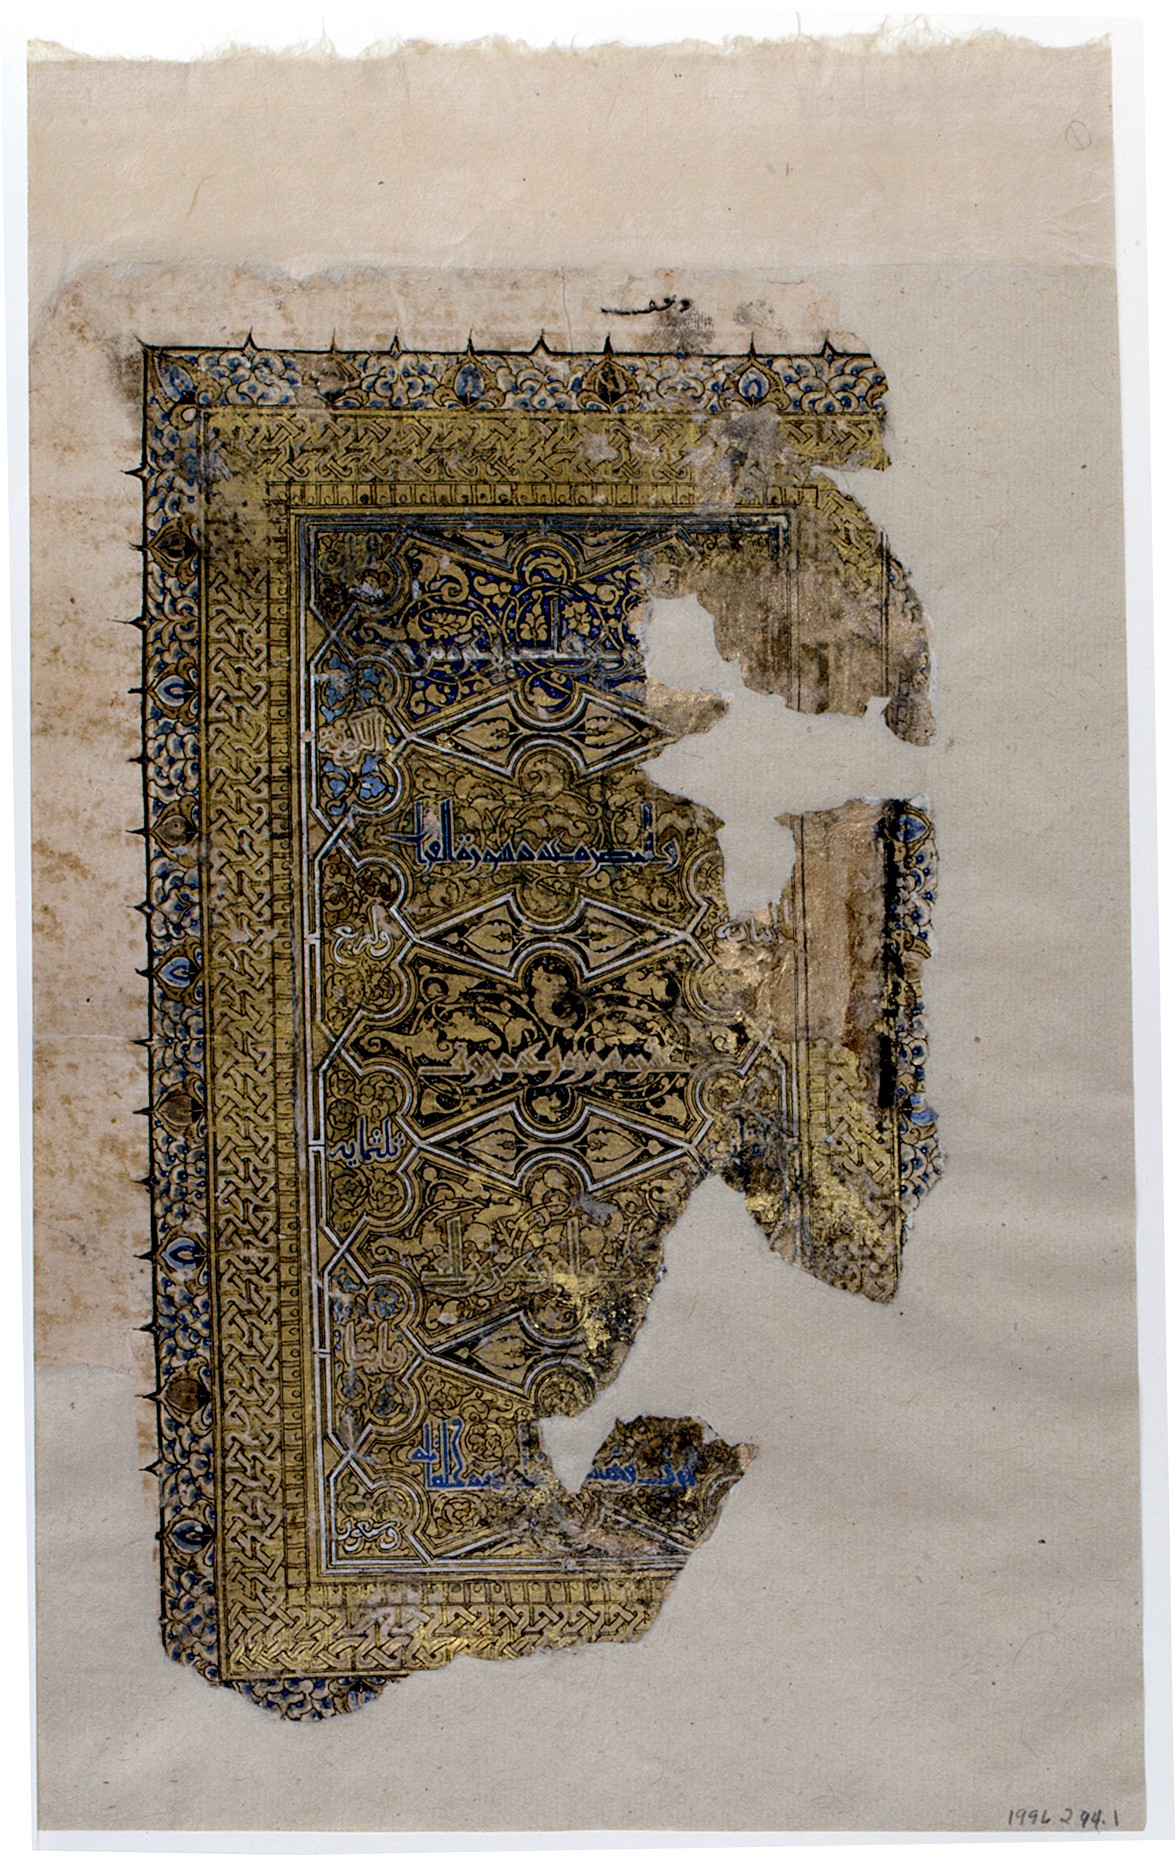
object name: folio from a non illustrated manuscript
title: Folio from a Qur'an Manuscript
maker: muhammad al-zanjani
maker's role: calligrapher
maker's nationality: iranian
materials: gold, ink, paper, watercolor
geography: iran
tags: qur'an